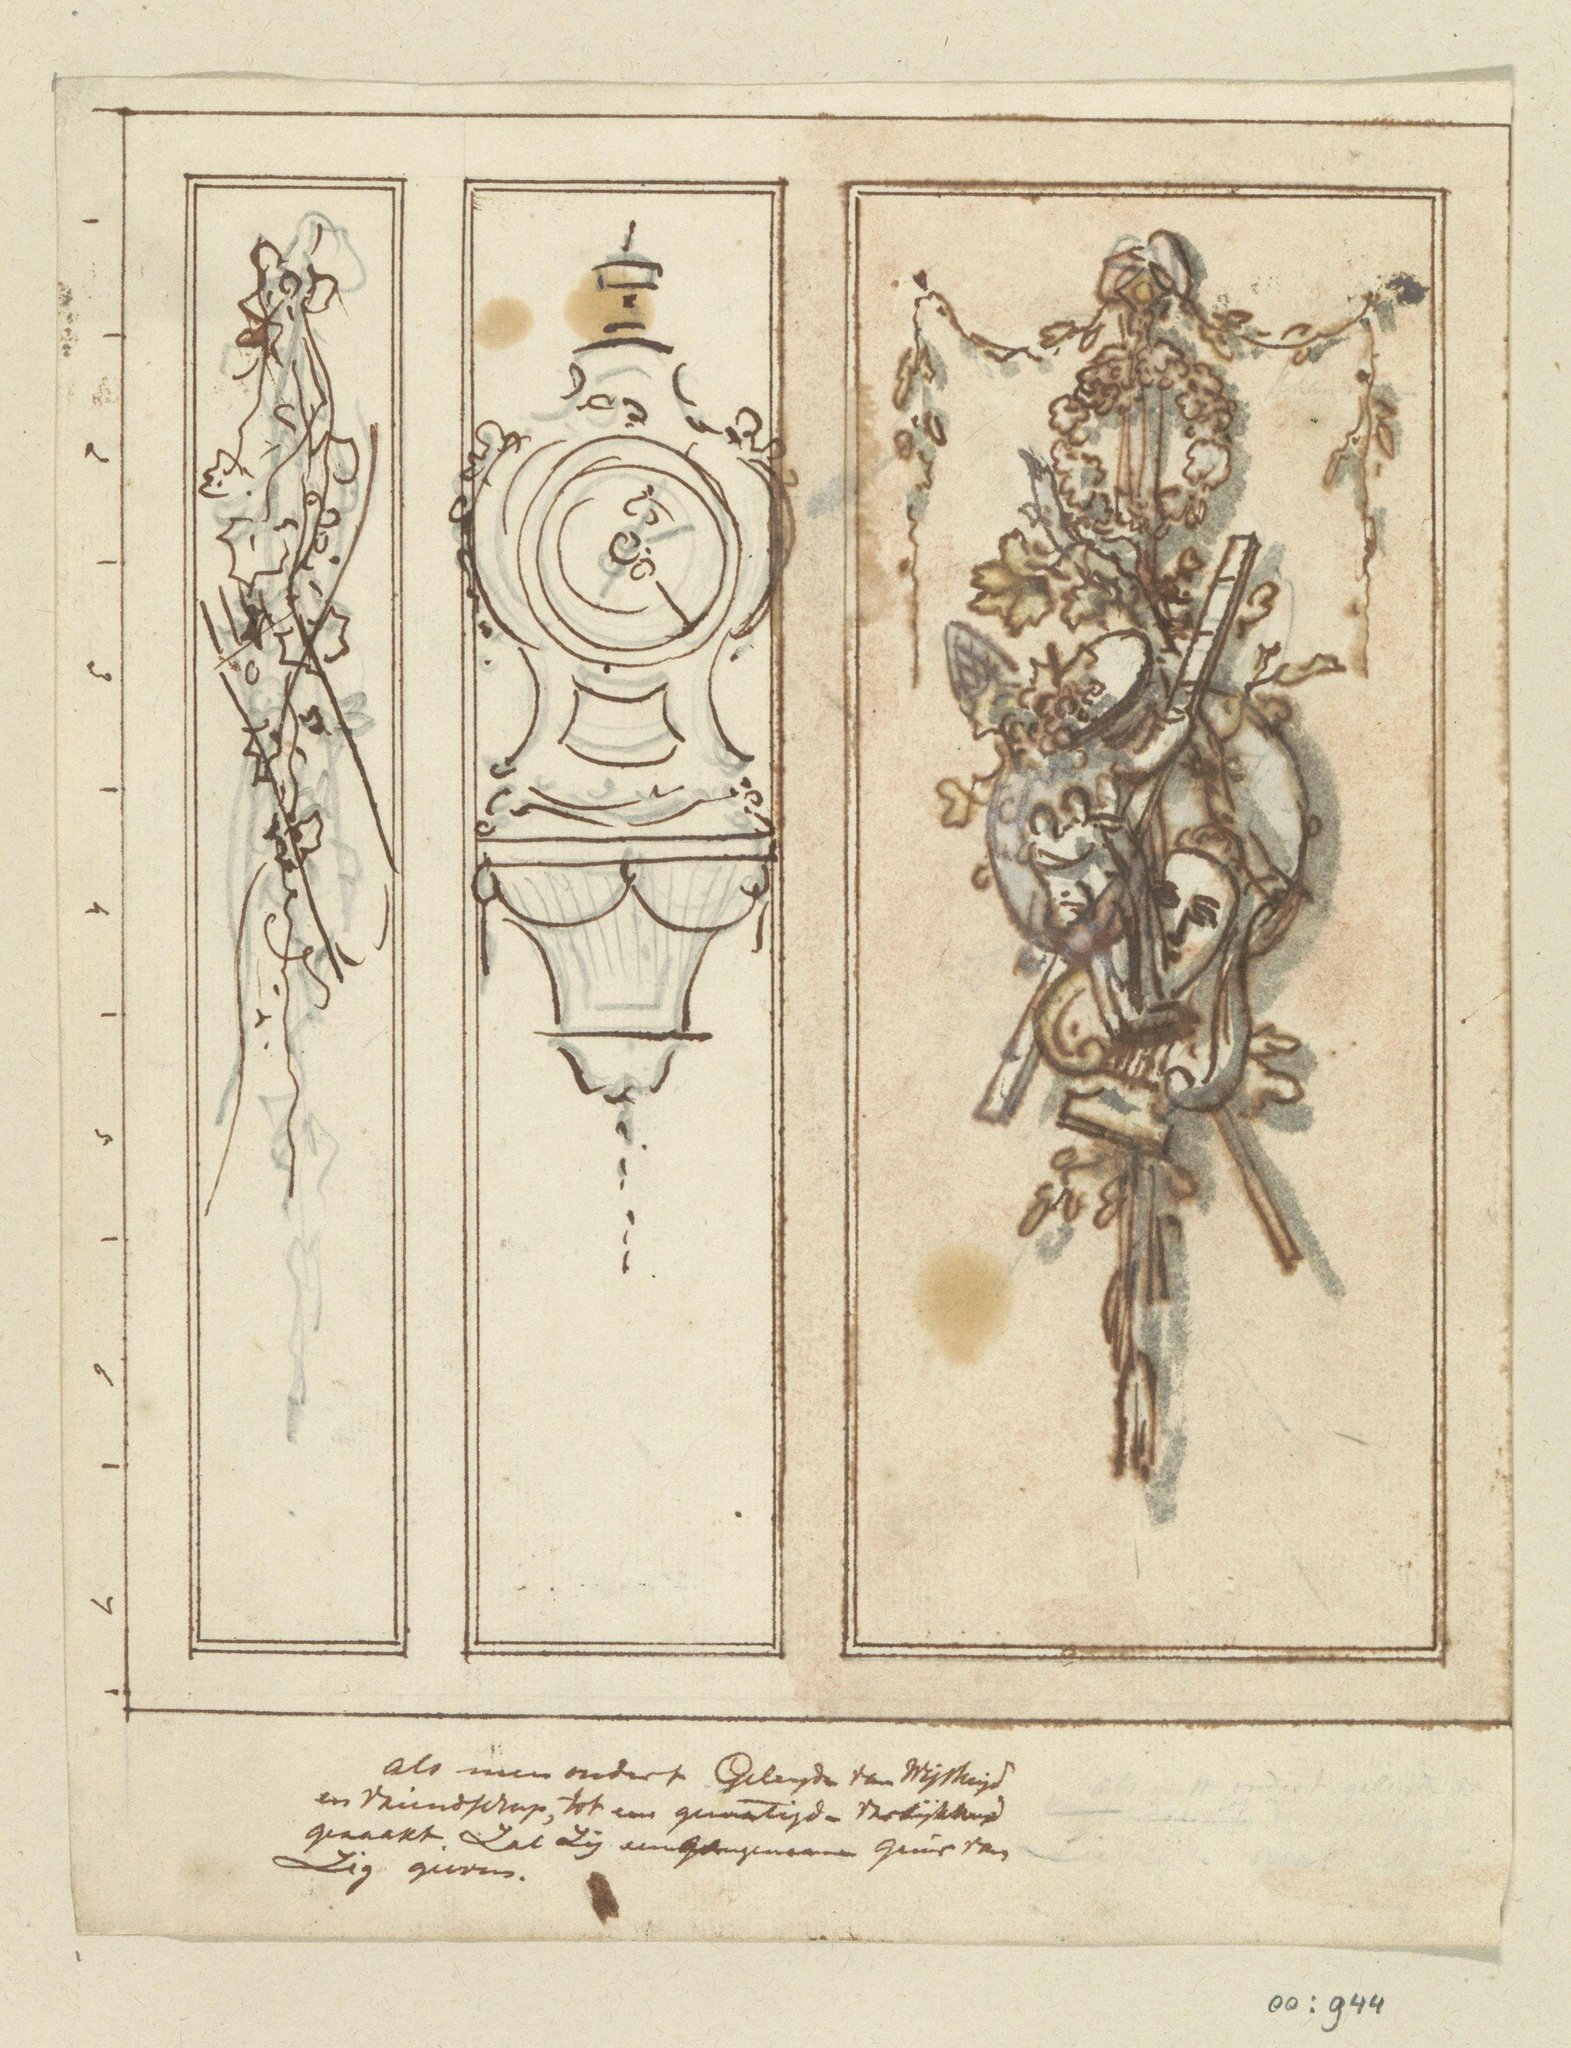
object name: album leaf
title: Ontwerptekening voor wanddecoratie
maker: jurriaan andriessen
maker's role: draughtsman, painter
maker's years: 1742-1819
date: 1760-1819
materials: ink, paper, pencil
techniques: brush, pen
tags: decorations (interior of the house)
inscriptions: inscription: ‘Als men nadert [...] van Wijsheyd/ (...)’